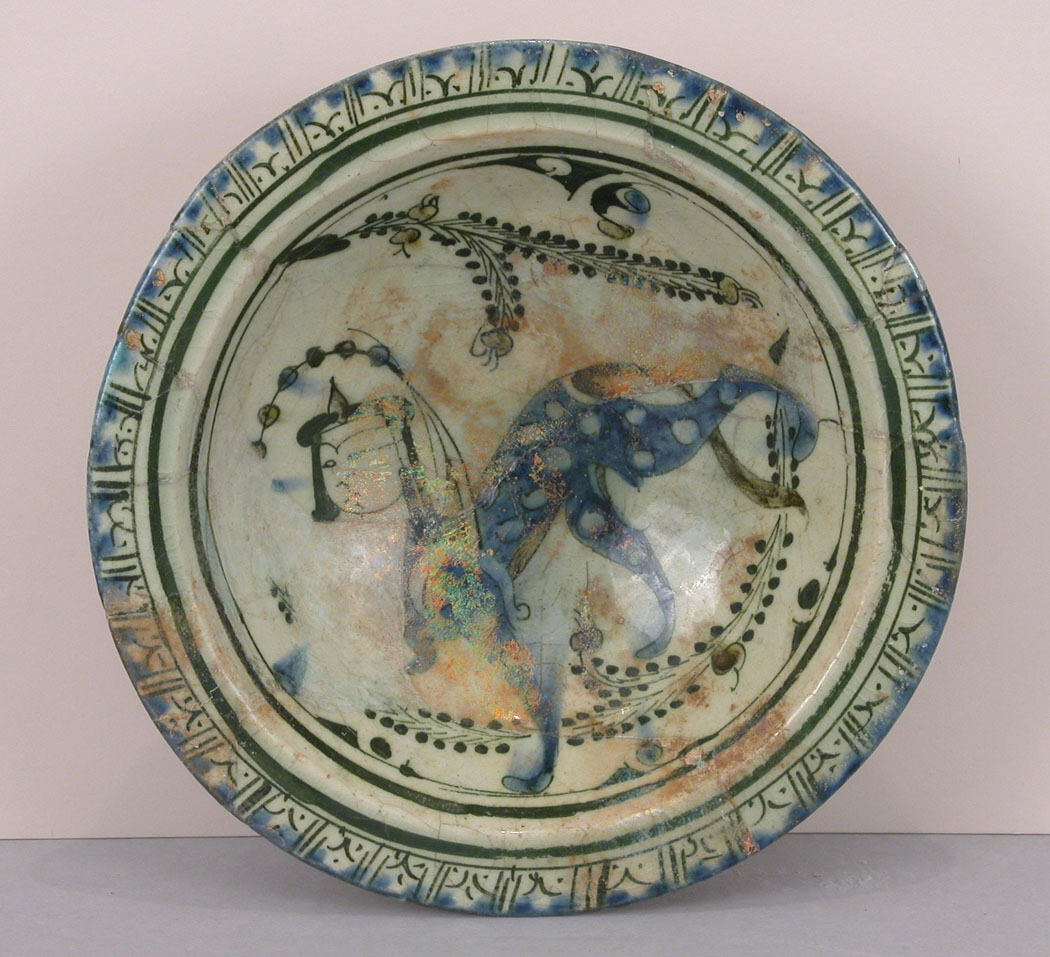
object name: bowl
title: Bowl with a Sphinx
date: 1101-1200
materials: glaze, stonepaste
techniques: painting, underglaze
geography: syria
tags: sphinx